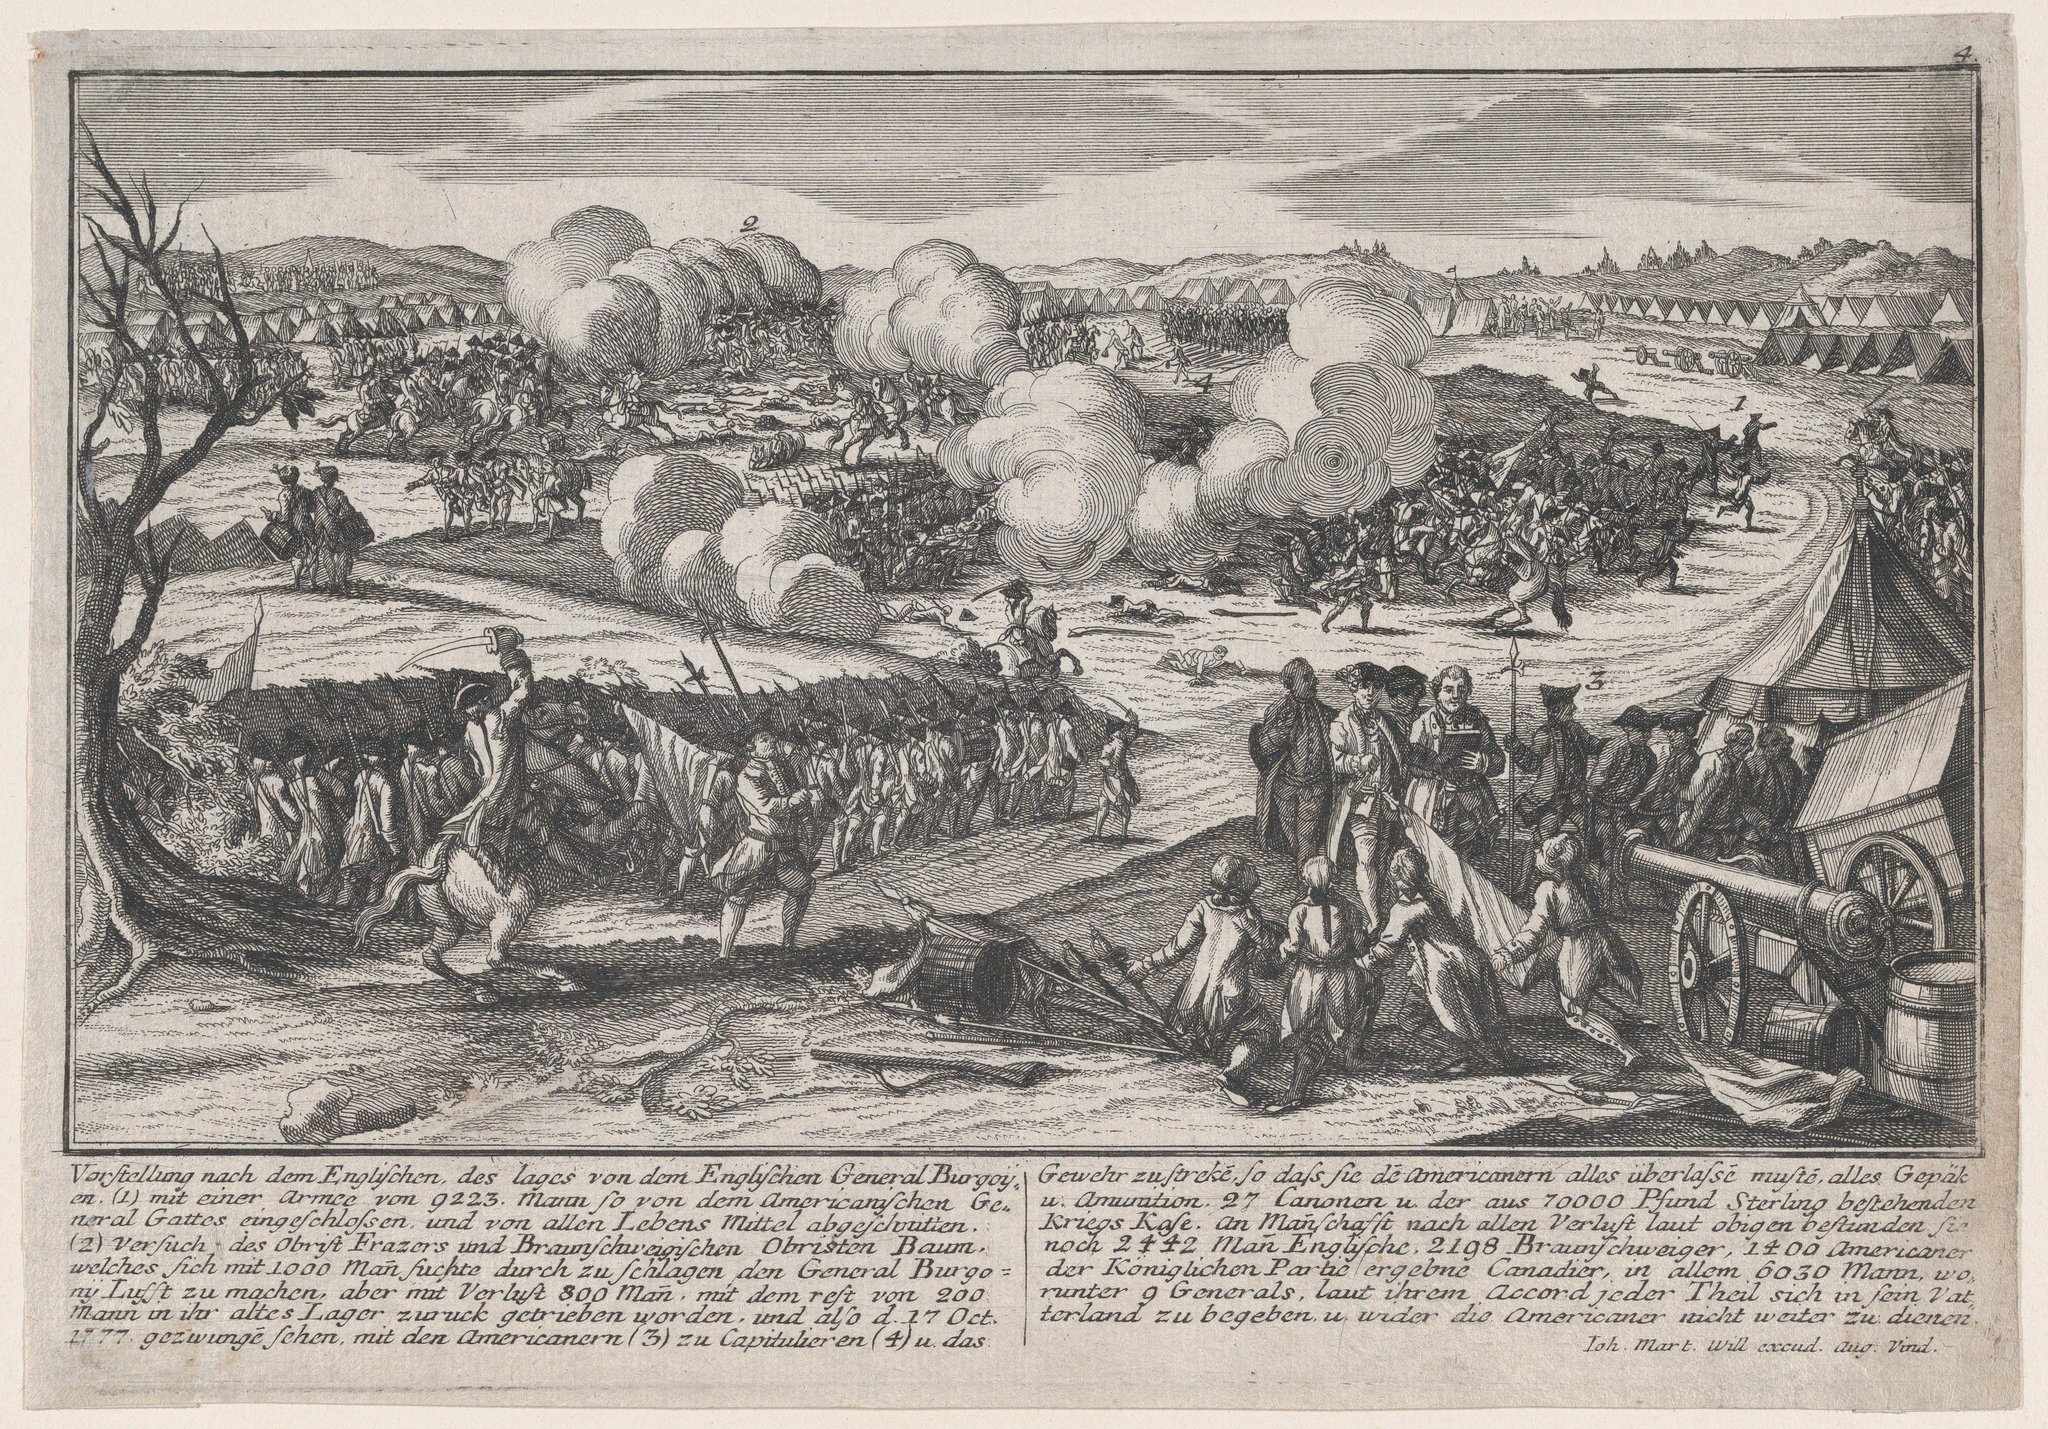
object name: print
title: Battle of Saratoga, September 19, 1777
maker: johann martin will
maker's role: publisher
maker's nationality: german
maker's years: 1727-1806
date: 1777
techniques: engraving, etching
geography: germany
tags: battles,cannons,american revolution,men,horses